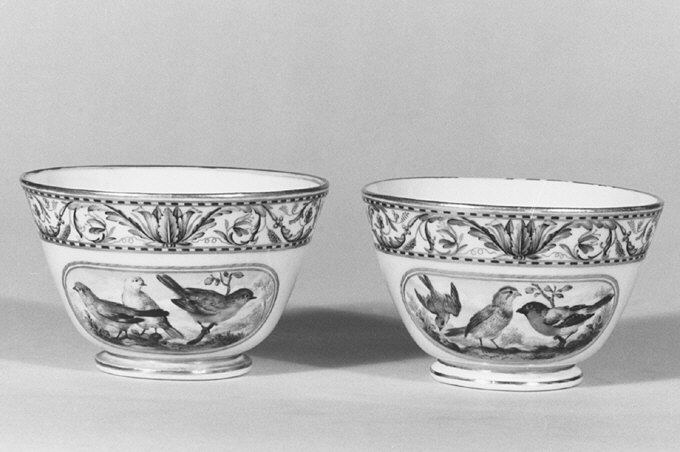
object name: saucer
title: Saucer (part of a service)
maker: meissen manufactory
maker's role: manufactory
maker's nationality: german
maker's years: 1710-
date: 1780-1785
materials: hard paste porcelain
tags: birds